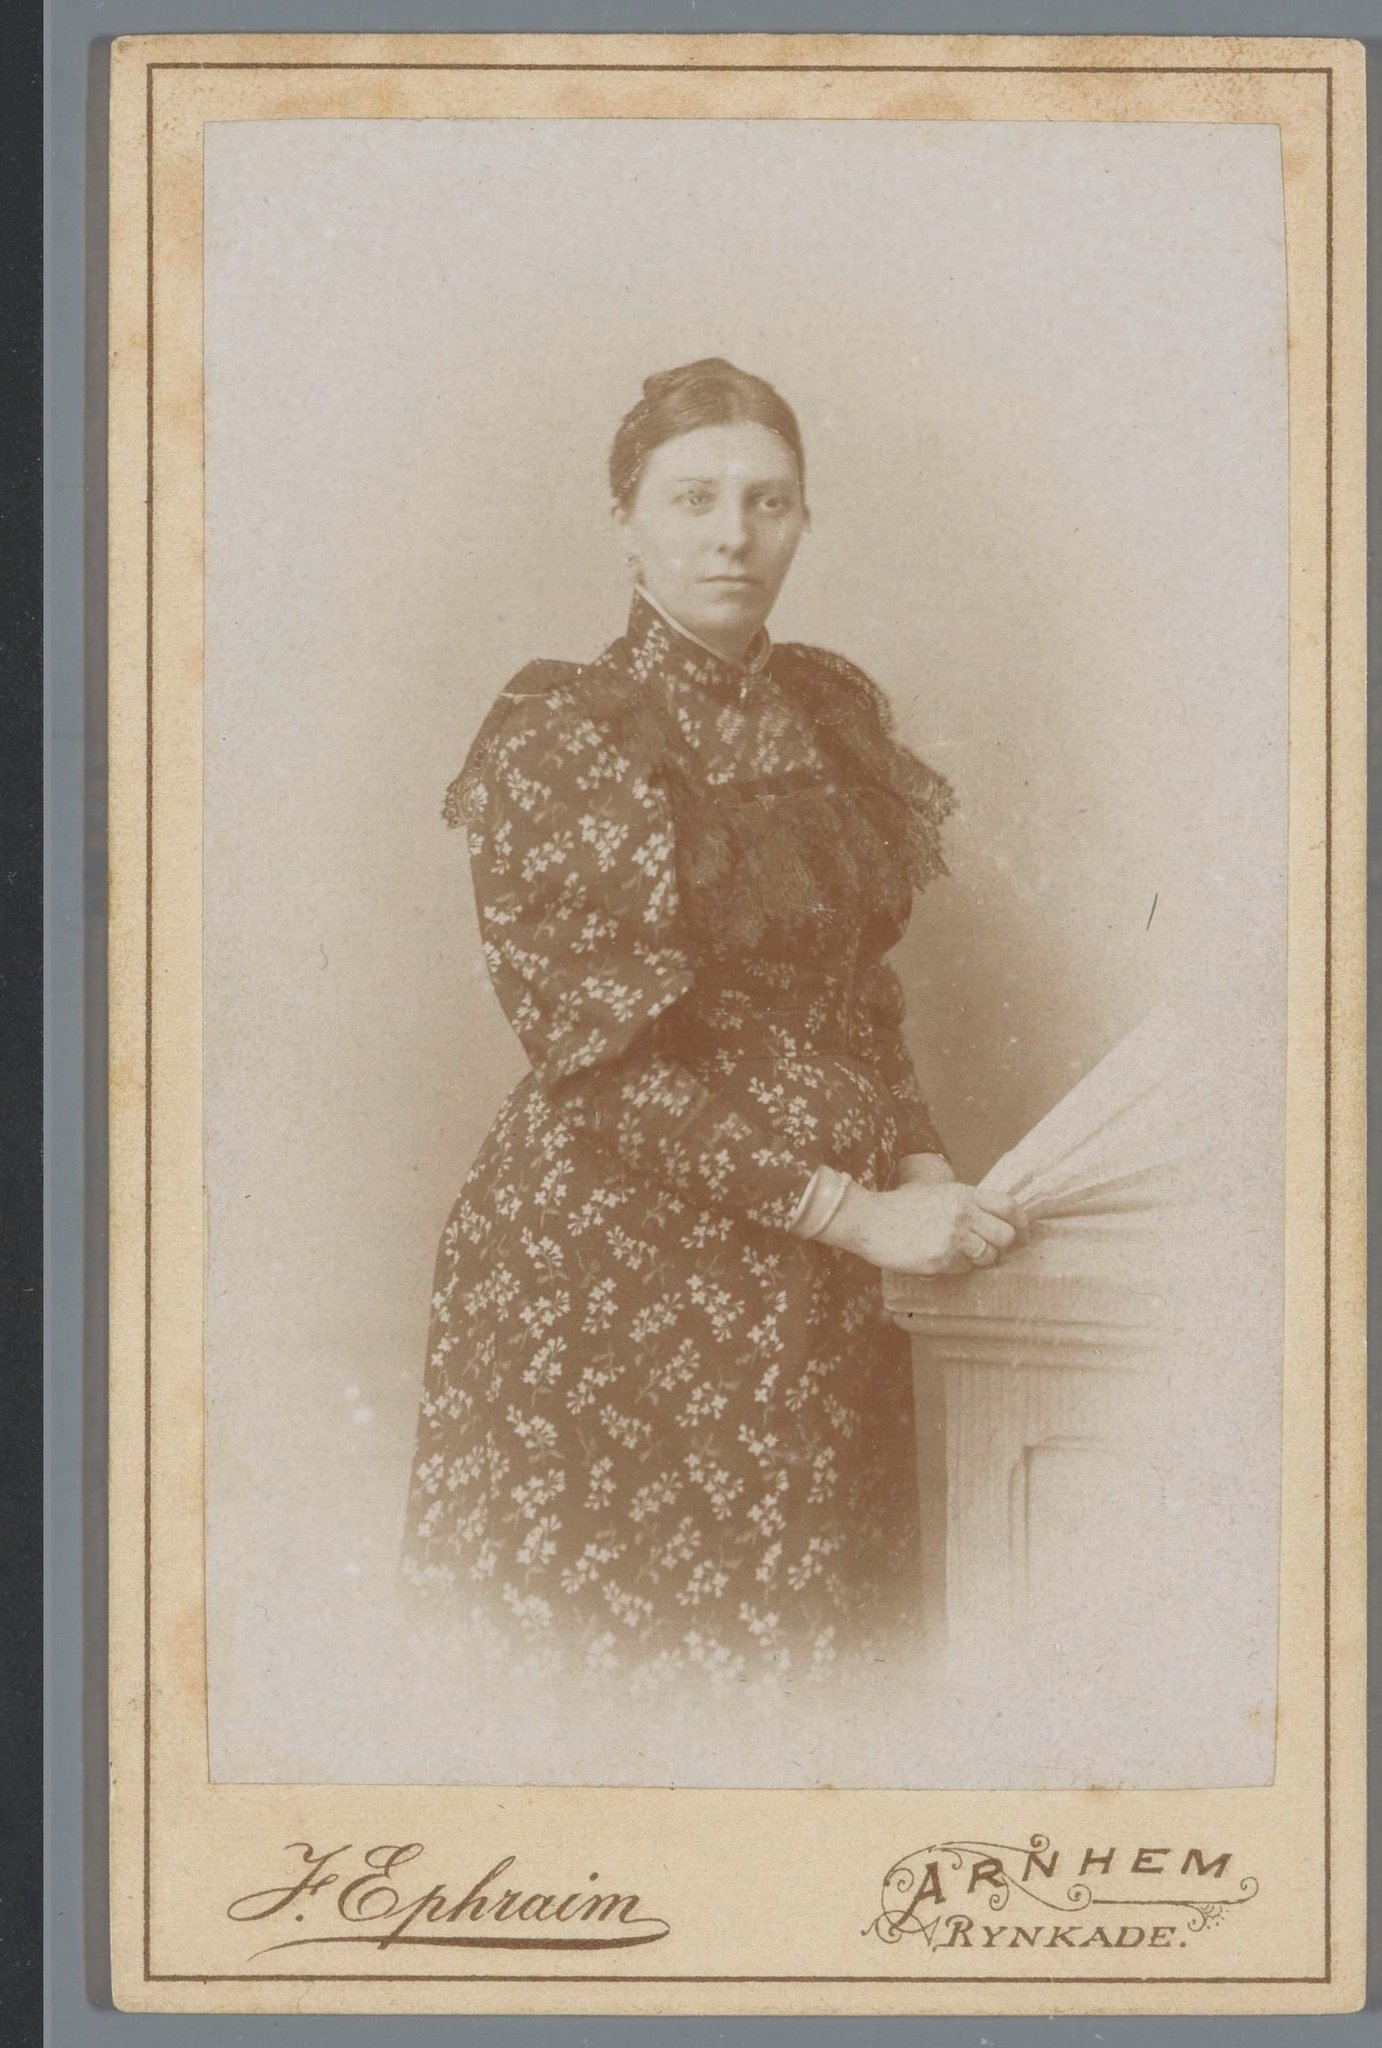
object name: photograph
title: Portret van een onbekende vrouw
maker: johannes ephraim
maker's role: fotograaf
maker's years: 1838-1921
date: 1880-1905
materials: paper, cardboard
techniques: collodion silver print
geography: arnhem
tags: adult woman, anonymous historical person portrayed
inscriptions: address: ‘ARNHEM/ Rynkade 53.’, inscription: ‘Les clichés/ sont conservés.’